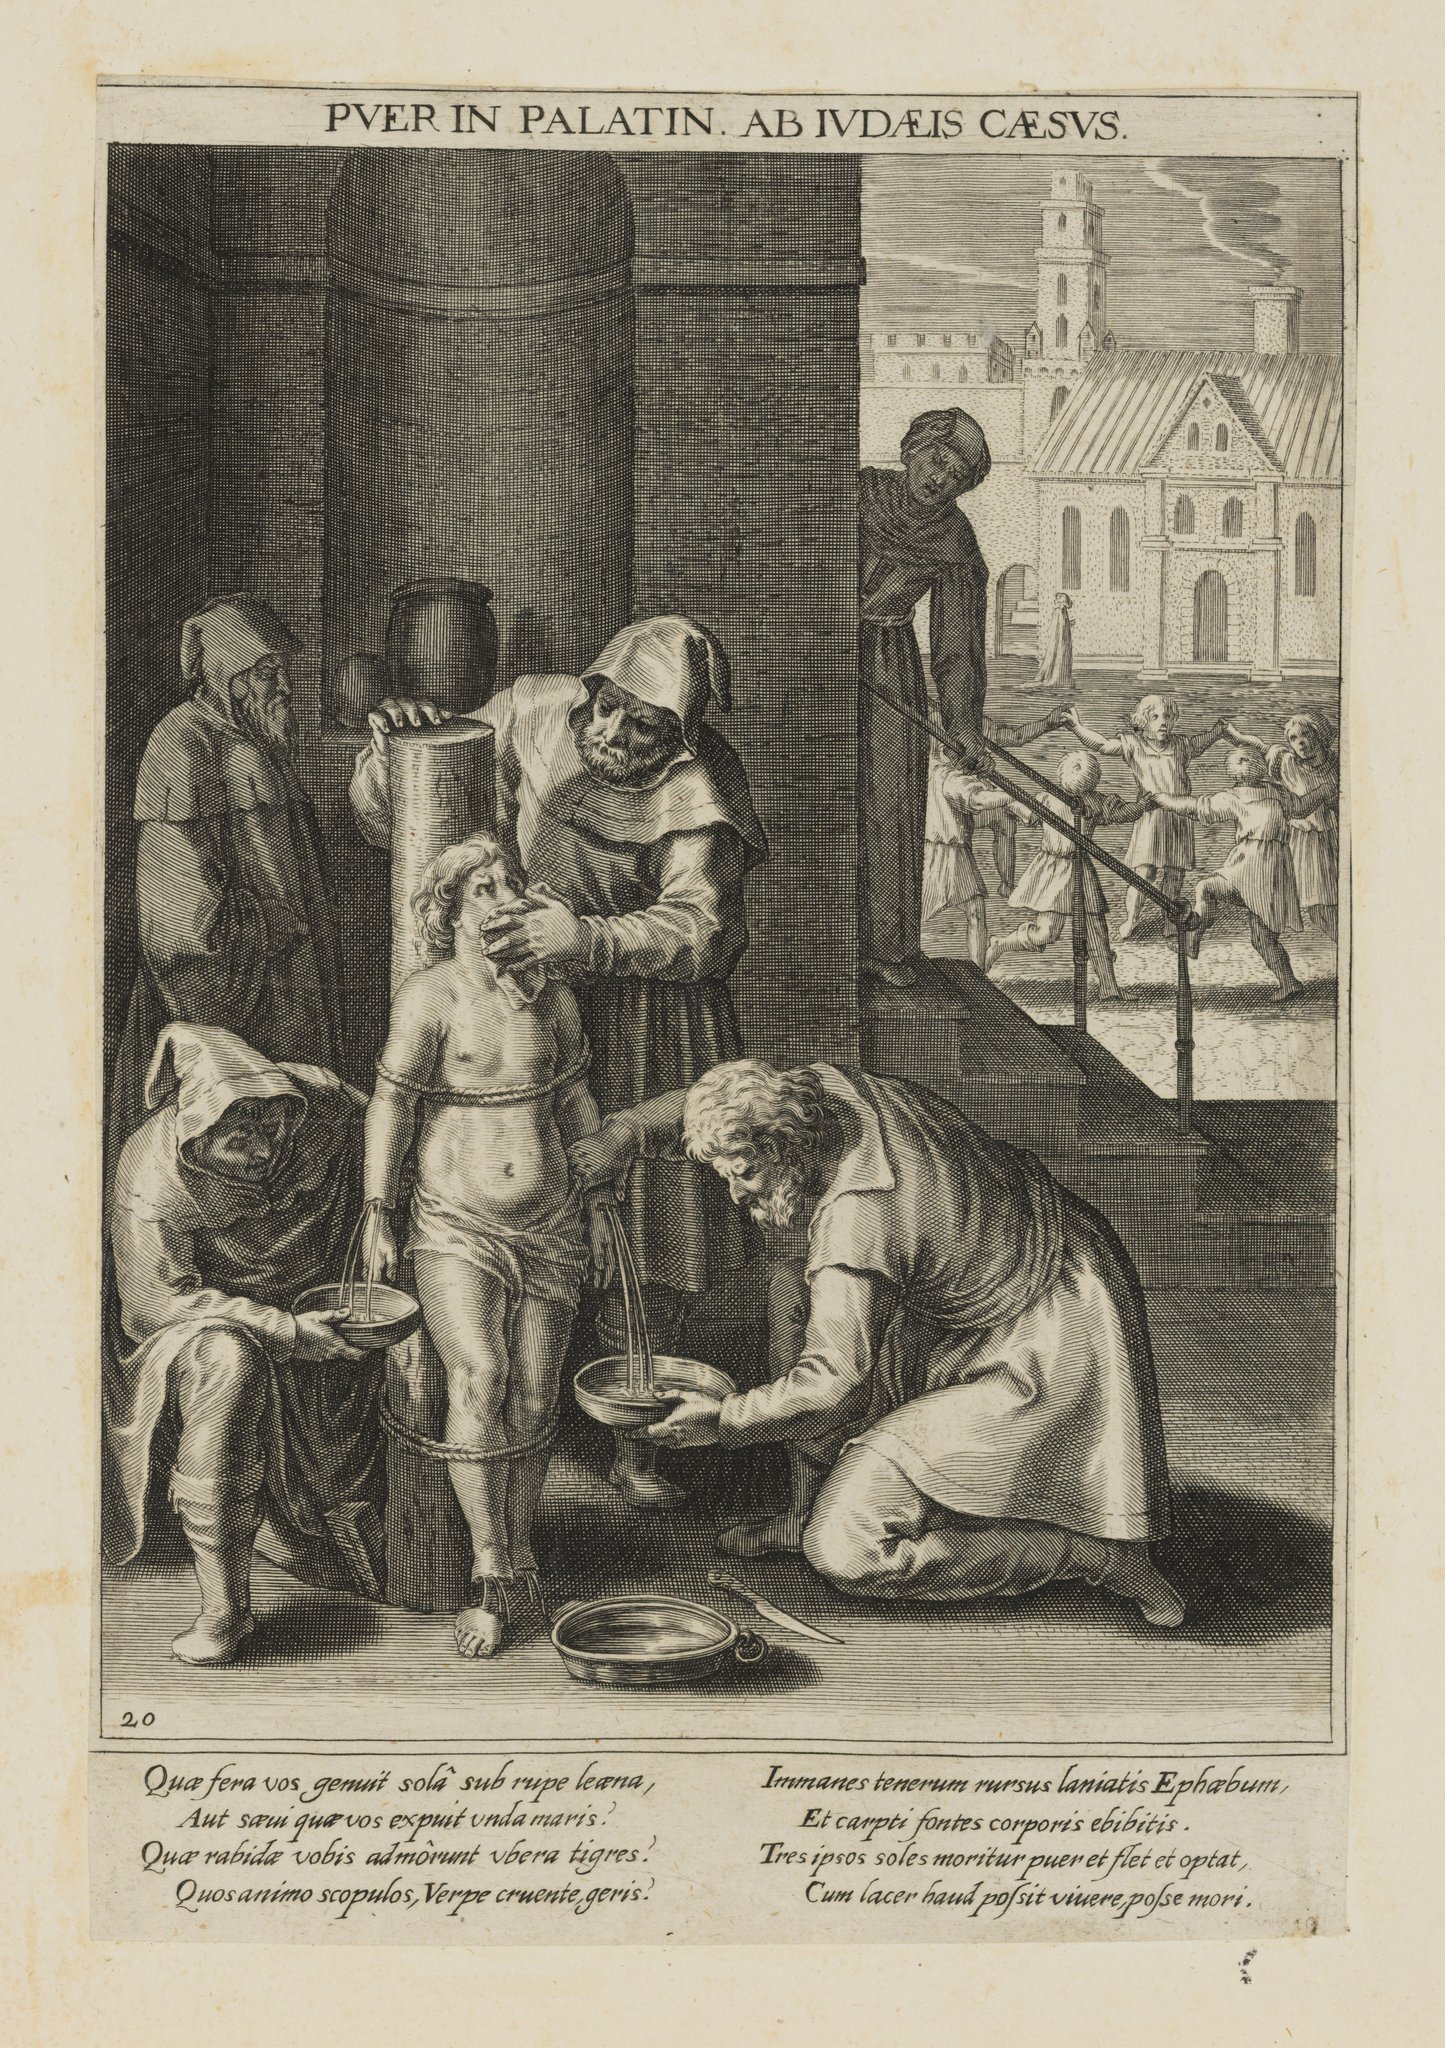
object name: print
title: Boy Killed in the Palatine, from Bavaria Sancta: The Life and Martyrdom of Holy Men and Women (Vol. III)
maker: raphael sadeler ii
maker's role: artist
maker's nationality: flemish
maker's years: 1584-1632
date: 1627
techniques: engraving